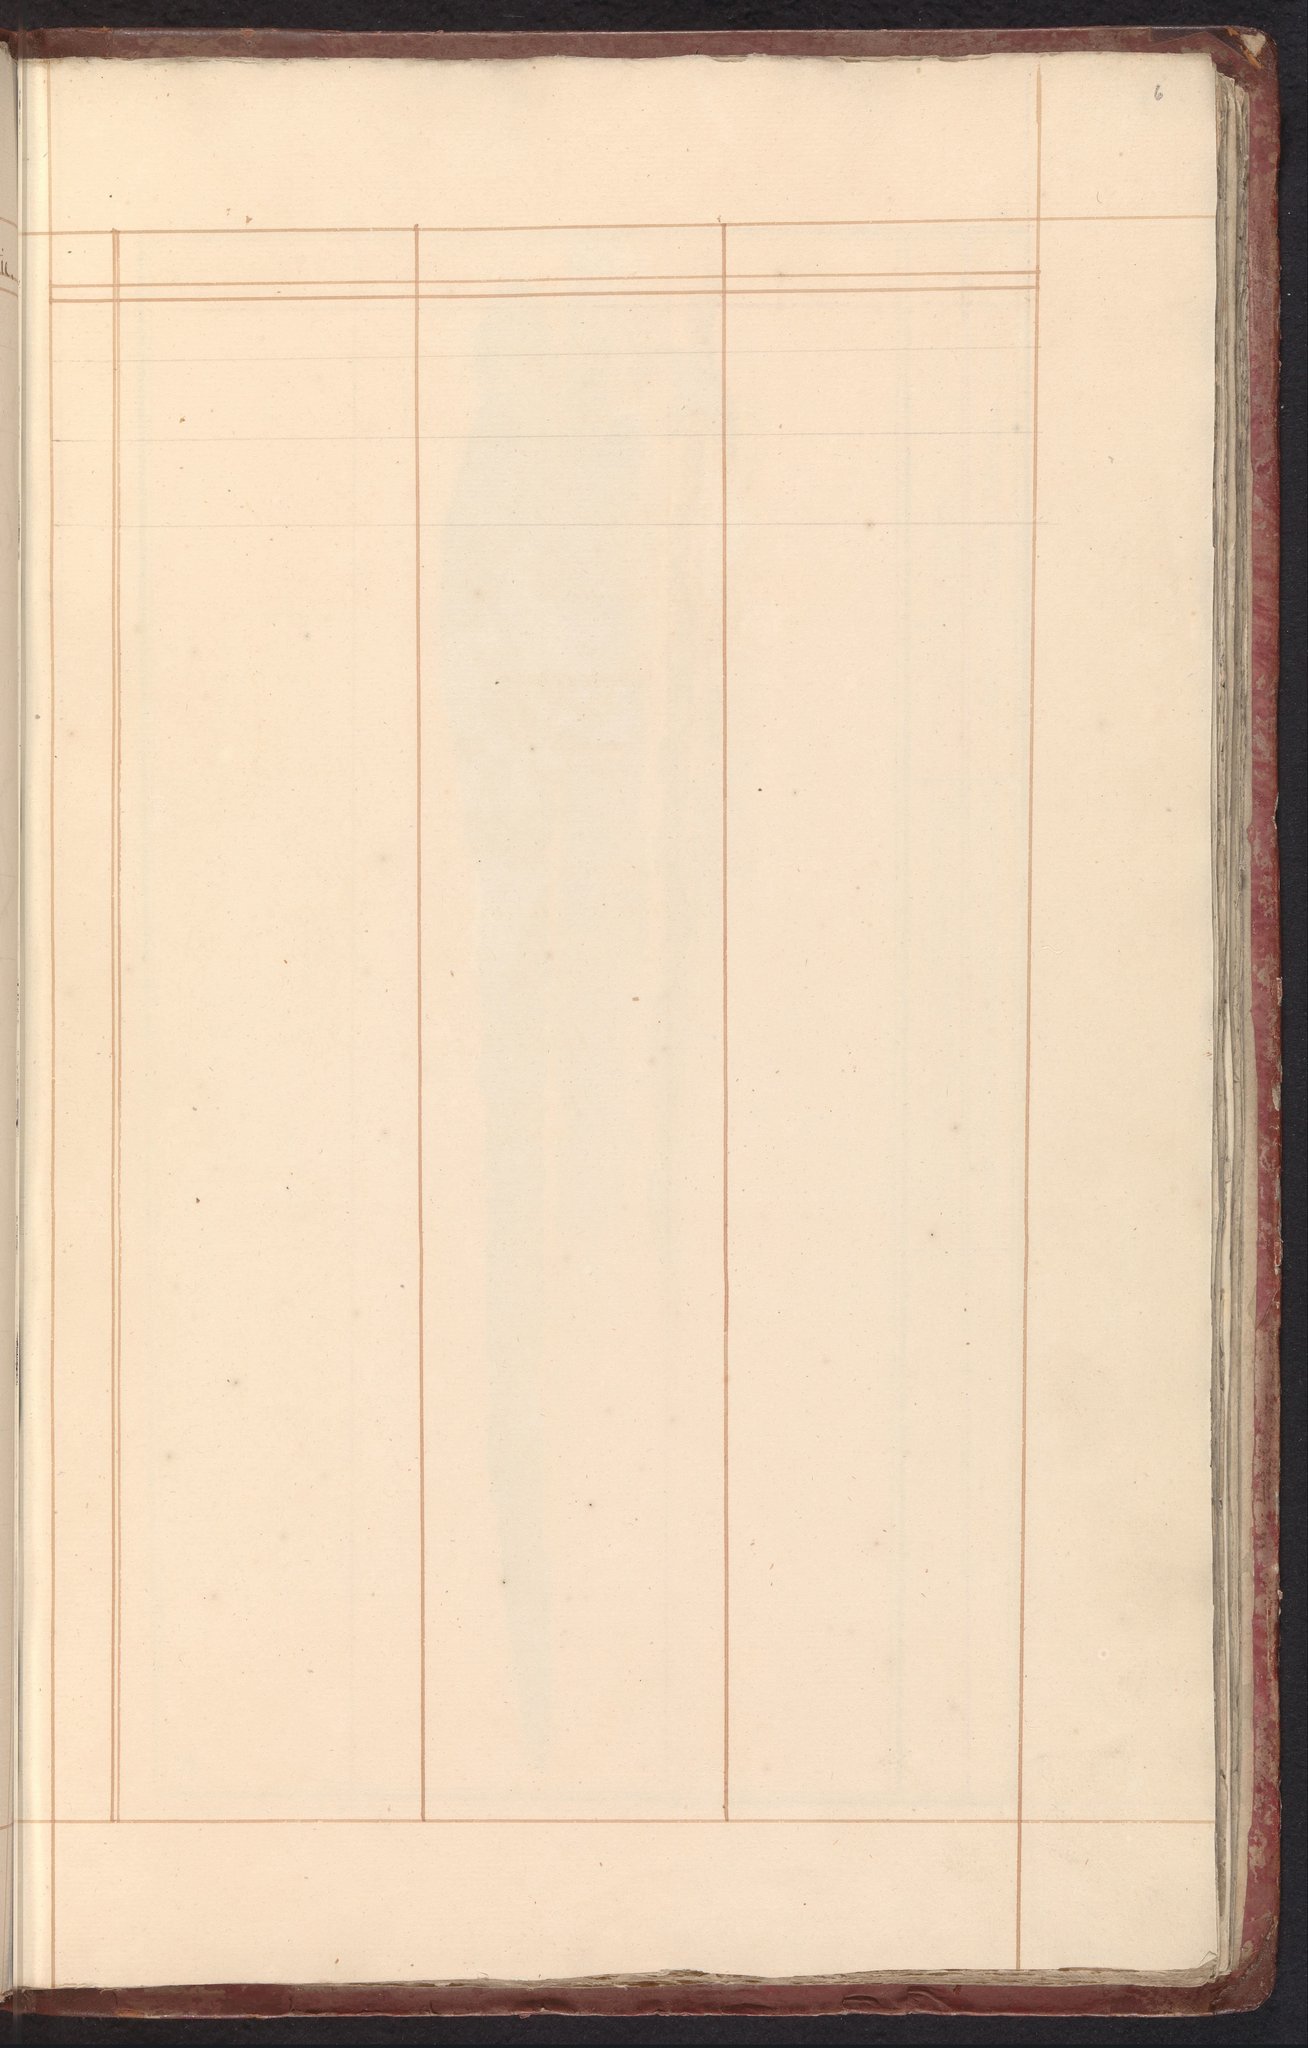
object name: manuscript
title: Oningevuld schema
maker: joseph van huerne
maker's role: kunstliefhebber, mecenas, verzamelaar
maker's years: 1752-1844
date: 1809-1814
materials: ink, paper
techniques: pen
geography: bruges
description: Oningevuld schema met drie kolommen. Onderdeel van het tweede album met tekeningen van viervoeters. Tweede van twaalf albums met tekeningen van dieren, vogels en planten bekend rond 1600, gemaakt in opdracht van keizer Rudolf II. Met toelichting in Nederlands, Latijn en Frans.